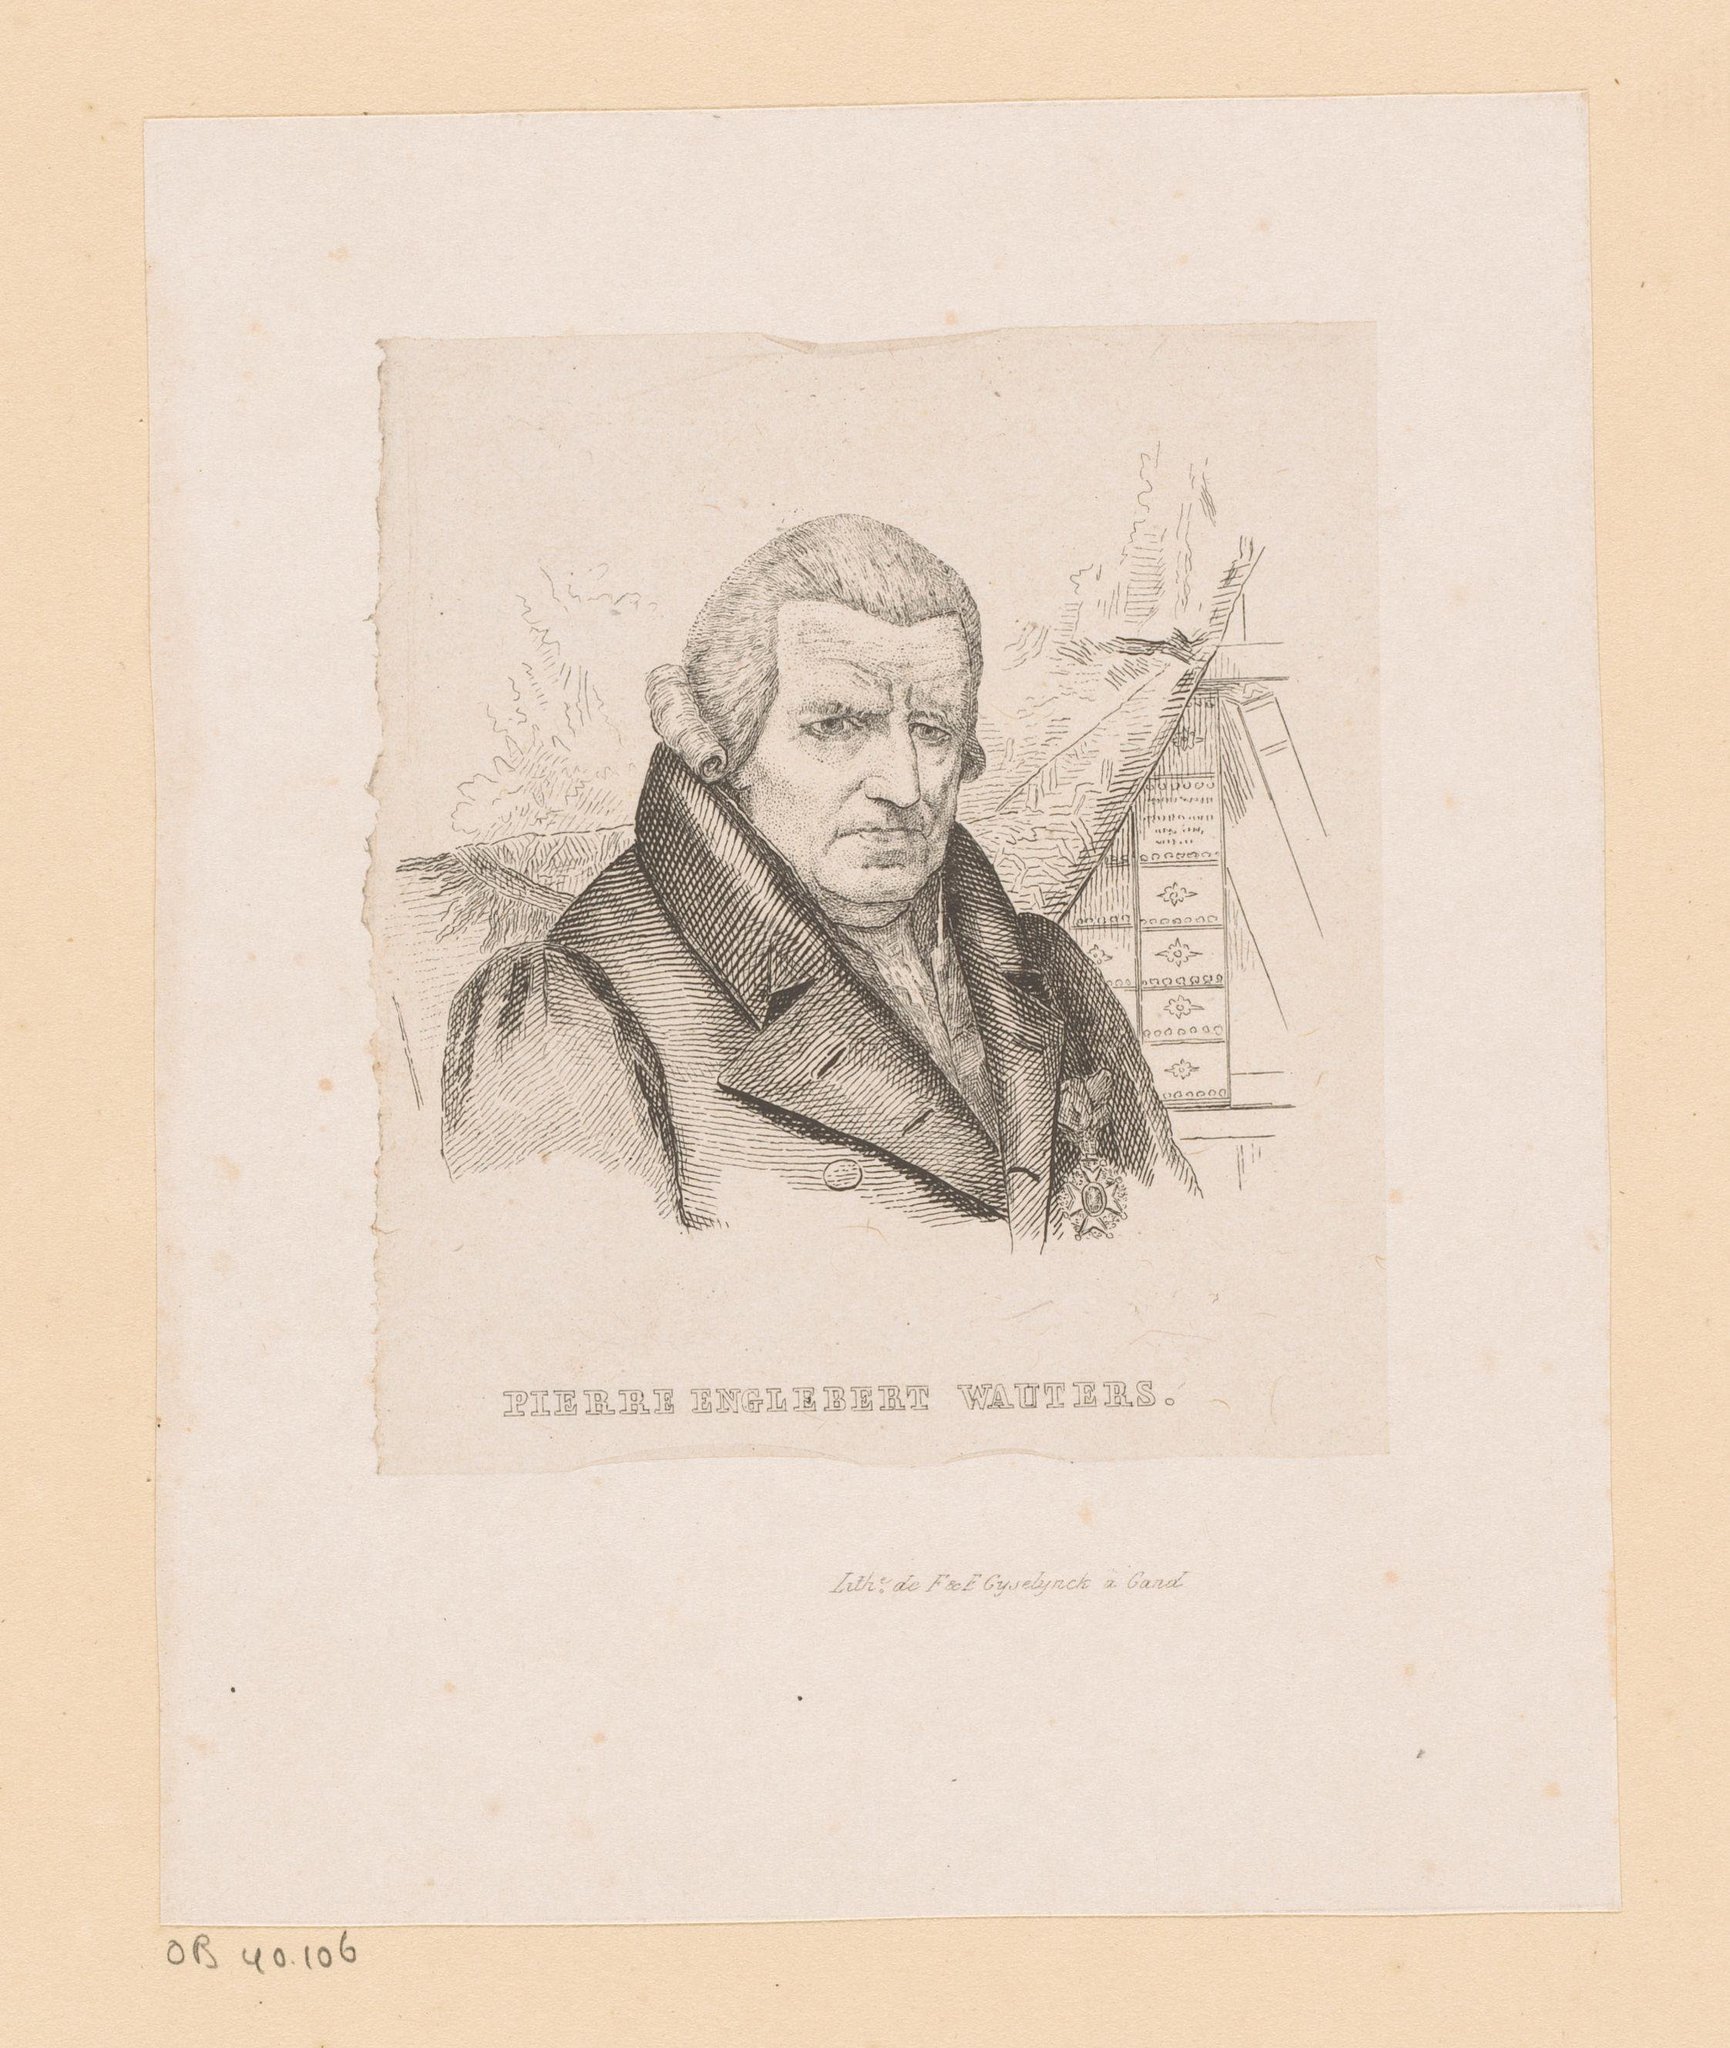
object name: print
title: Pierre Englebert Wauters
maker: Anonymous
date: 1830-1870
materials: paper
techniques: lithograph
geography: ghent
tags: adult man, historical persons